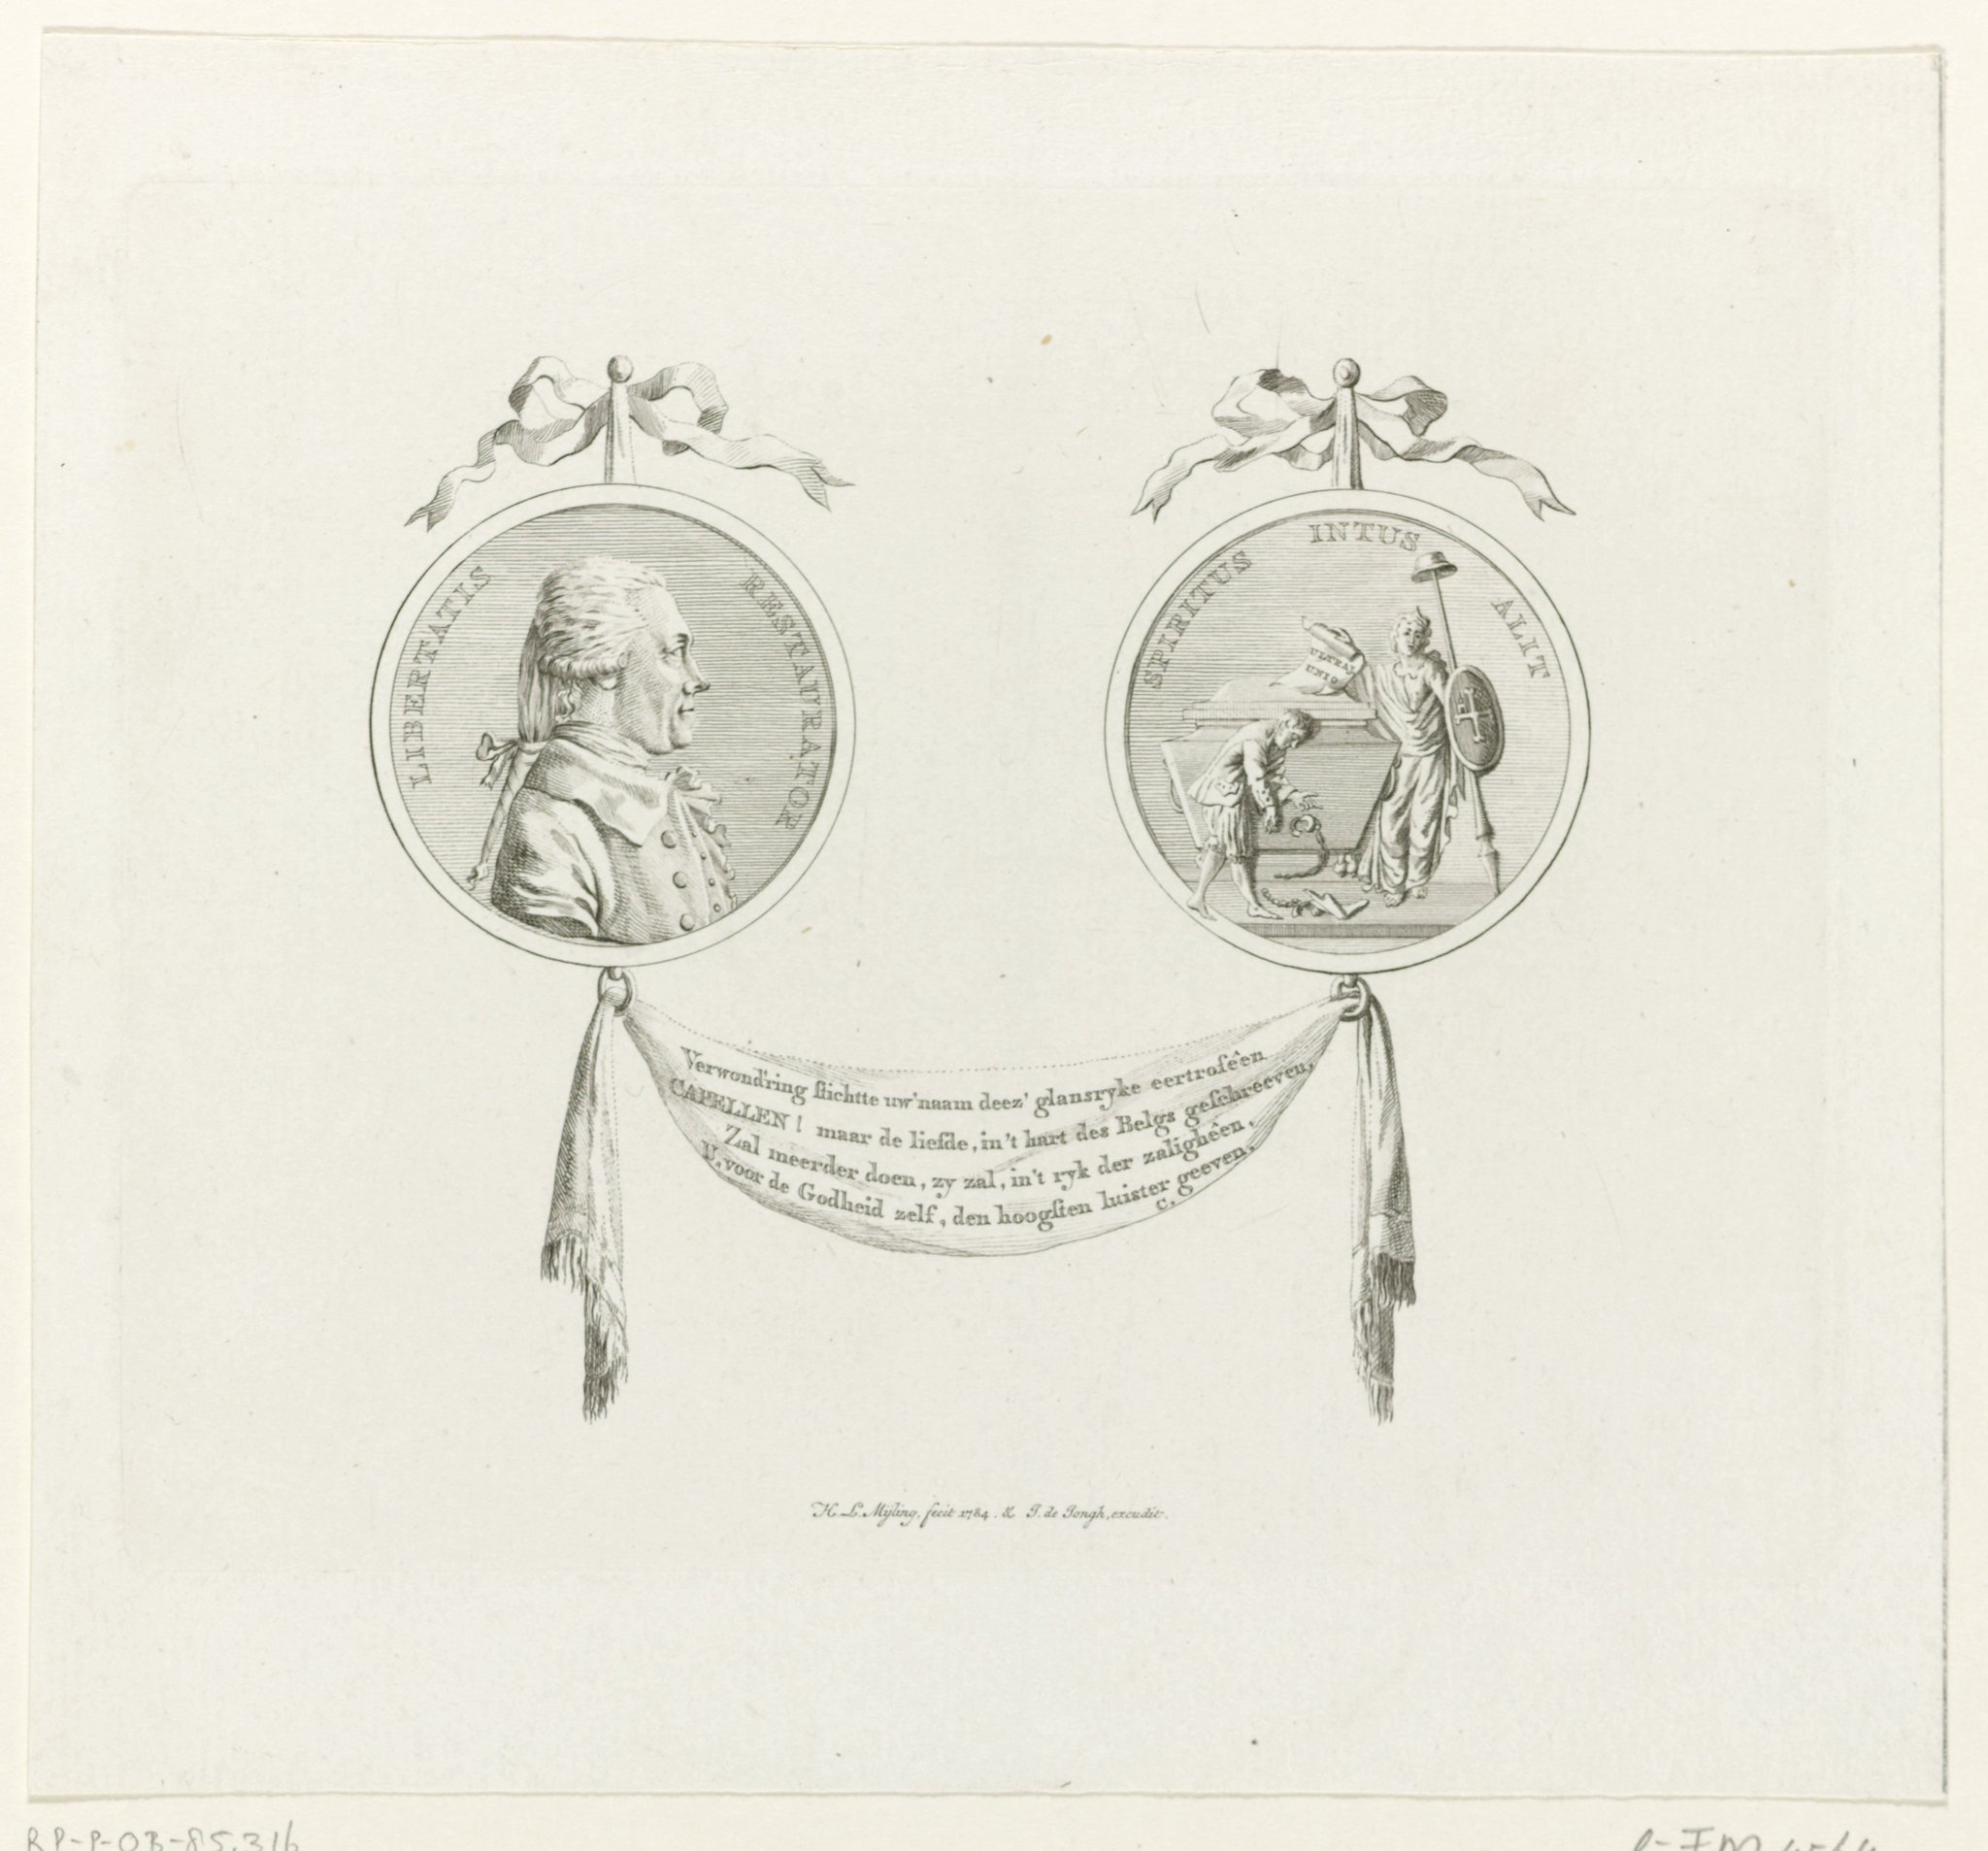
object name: print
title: Penning op het overlijden van Joan Derk van der Capellen tot den Pol, 1784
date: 1784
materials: paper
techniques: engraving, etching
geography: amsterdam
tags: politician, joan derk van der capellen tot den pol, medal (considered as a piece of sculpture, regardless of its specific function)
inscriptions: collector's mark: Lugt 2228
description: Penning op het overlijden van Joan Derk van der Capellen tot den Pol, 6 juni 1784. Beide zijden van de penning met daartussen een hangende doek waarop een vierregelig vers gesigneerd met de letter C.